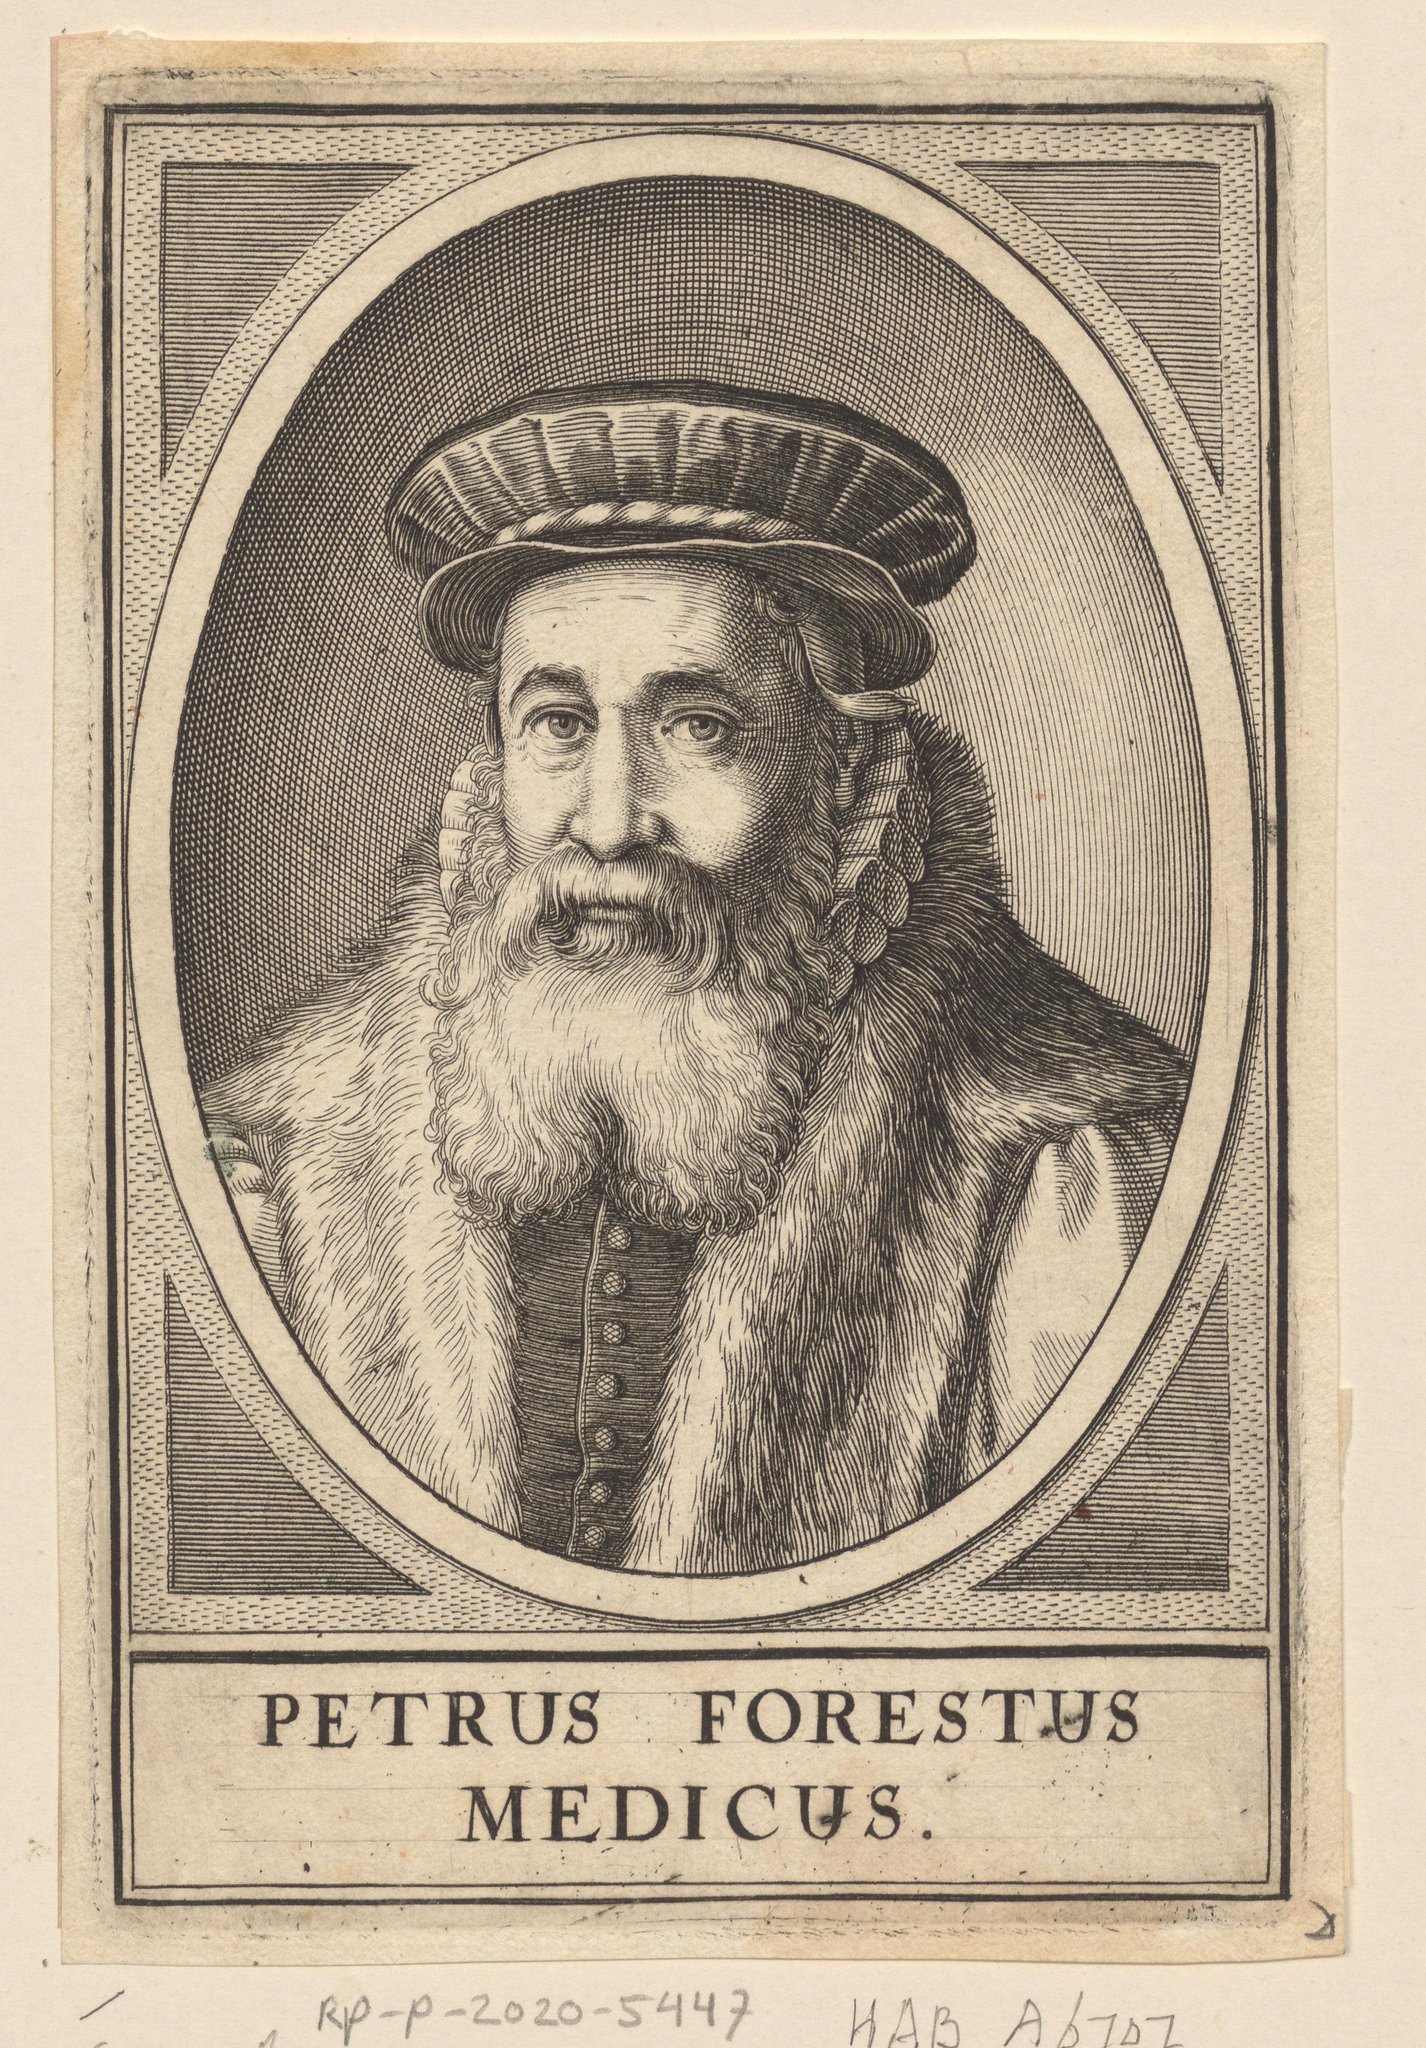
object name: print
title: Portret van Pieter van Foreest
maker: willem isaacsz. van swanenburg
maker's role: print maker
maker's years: 1580-1612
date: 1609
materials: paper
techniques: engraving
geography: leiden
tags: historical persons, physician, doctor (+ portrait of scholar, scientist)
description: Prent waarschijnlijk uit: Icones ad vivum delineatae et expressae, virorum clariorum qui praecipue scriptis Academiam Lugduno Batavam illustrarunt. Leiden: Andries Clouck, 1609. De plaat is, met tekst op het verso, ook gebruikt in publicaties uit 1613, 1617 en 1625. Mogelijk is de prent in deze staat en zonder tekst op verso ook gebruikt voor 'Pourtraits de les celebres et plus renommés professeurs (...)', uitgegeven door Pieter van der Aa ca. 1715, zie Van Someren 146.